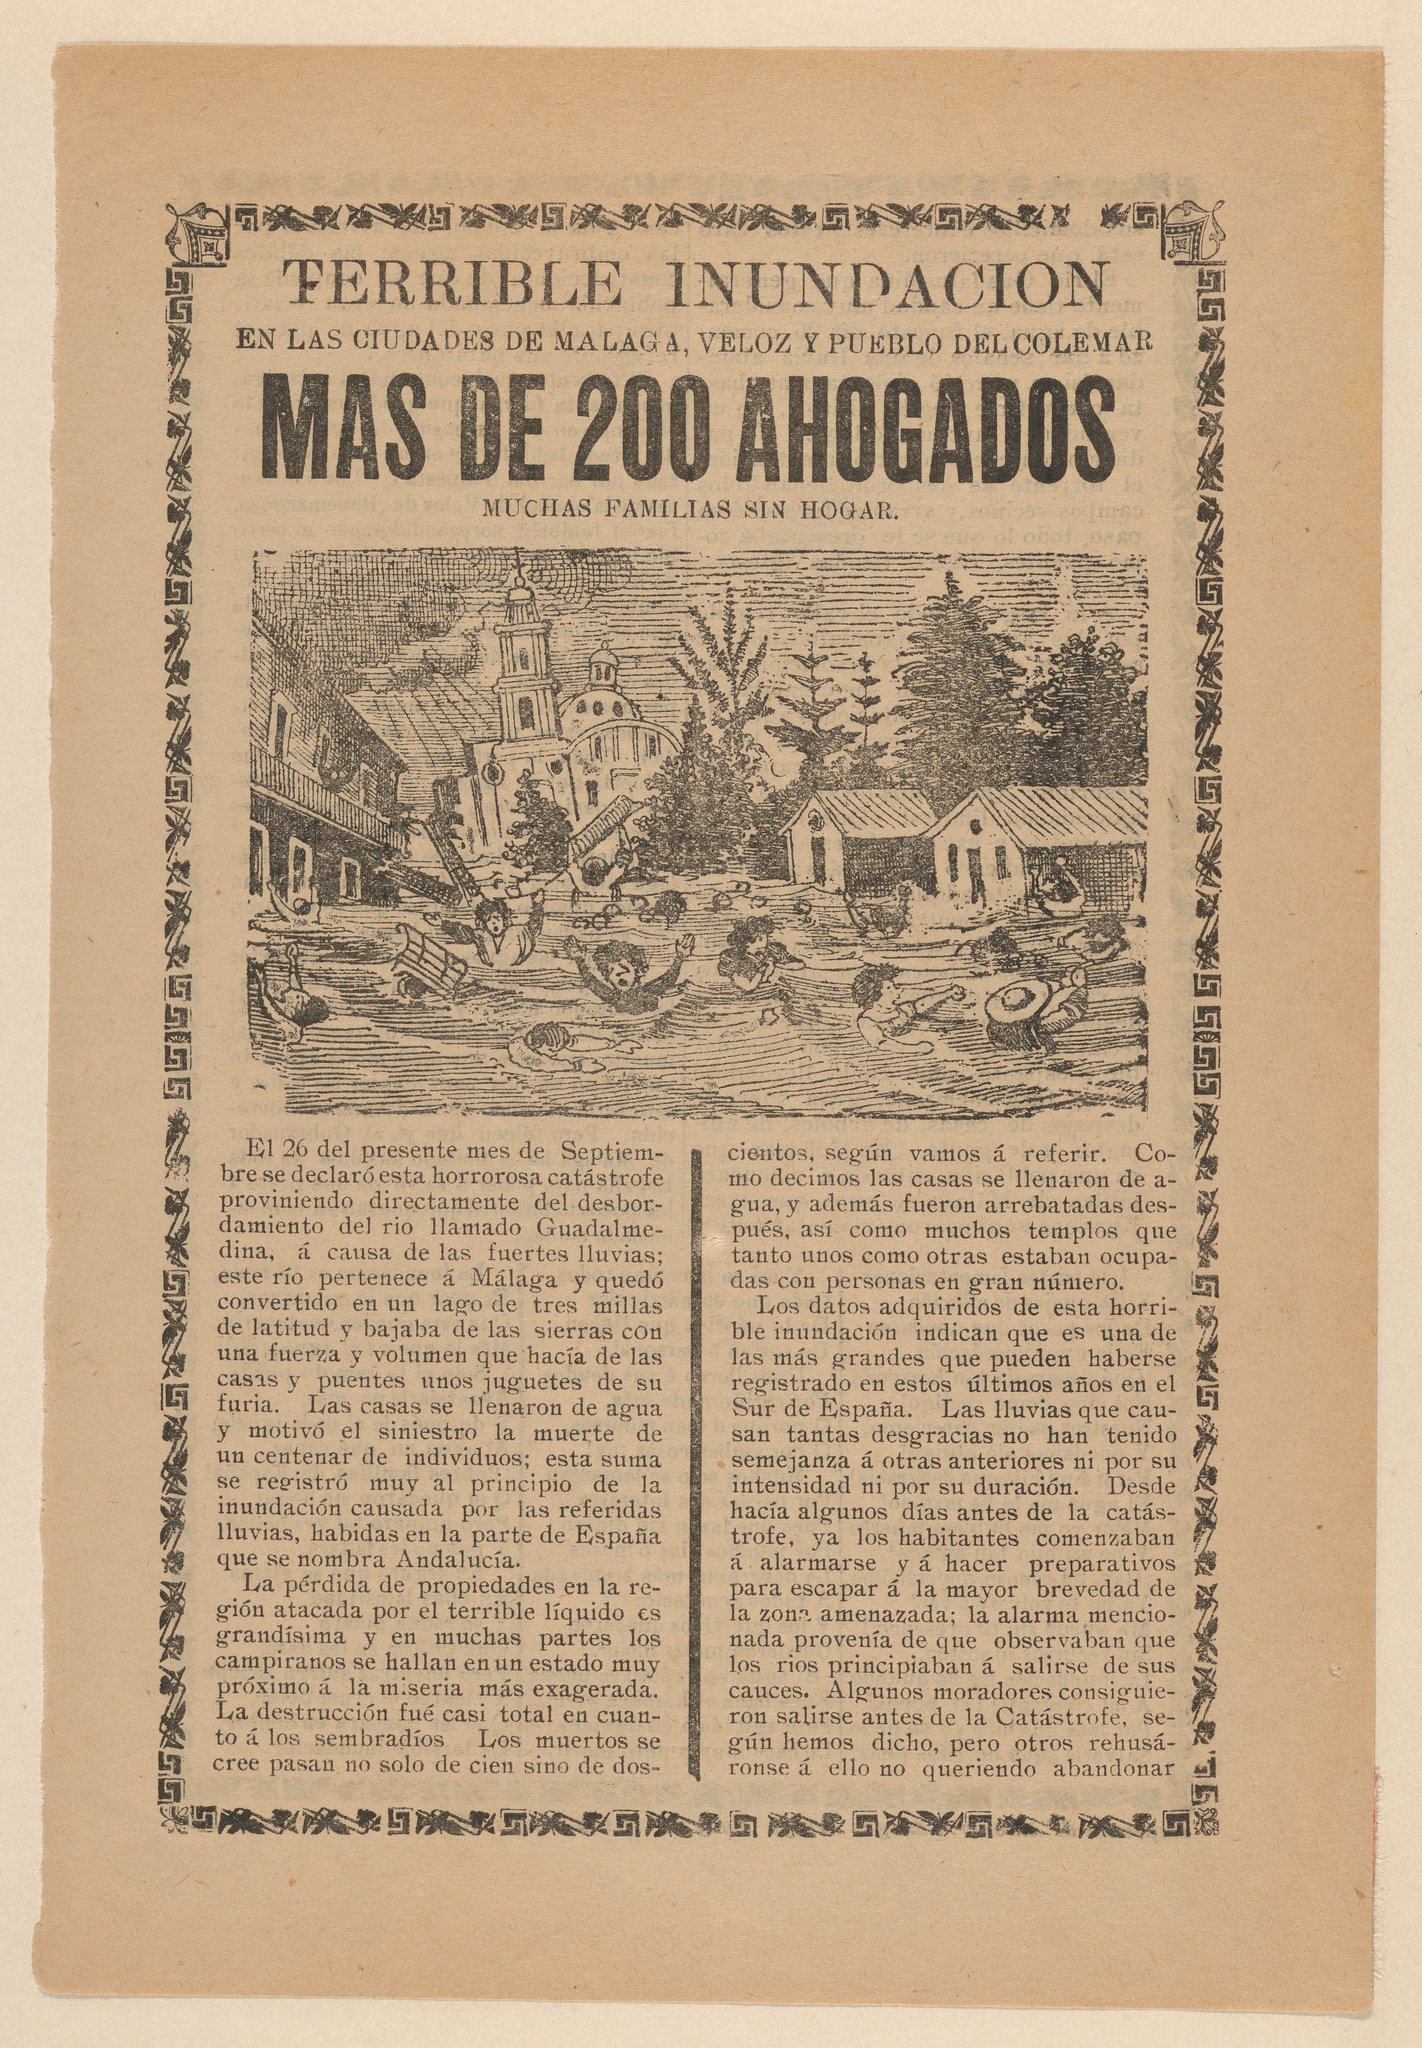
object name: print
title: Broadsheet relating to the terrible flood in the towns of Malaga, Veloz and Pueblo del Colemar where more than 200 drowned and many families left without homes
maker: josé guadalupe posada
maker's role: artist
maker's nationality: mexican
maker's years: 1852-1913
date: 1907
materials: paper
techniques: letterpress, lithography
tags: towns,floods